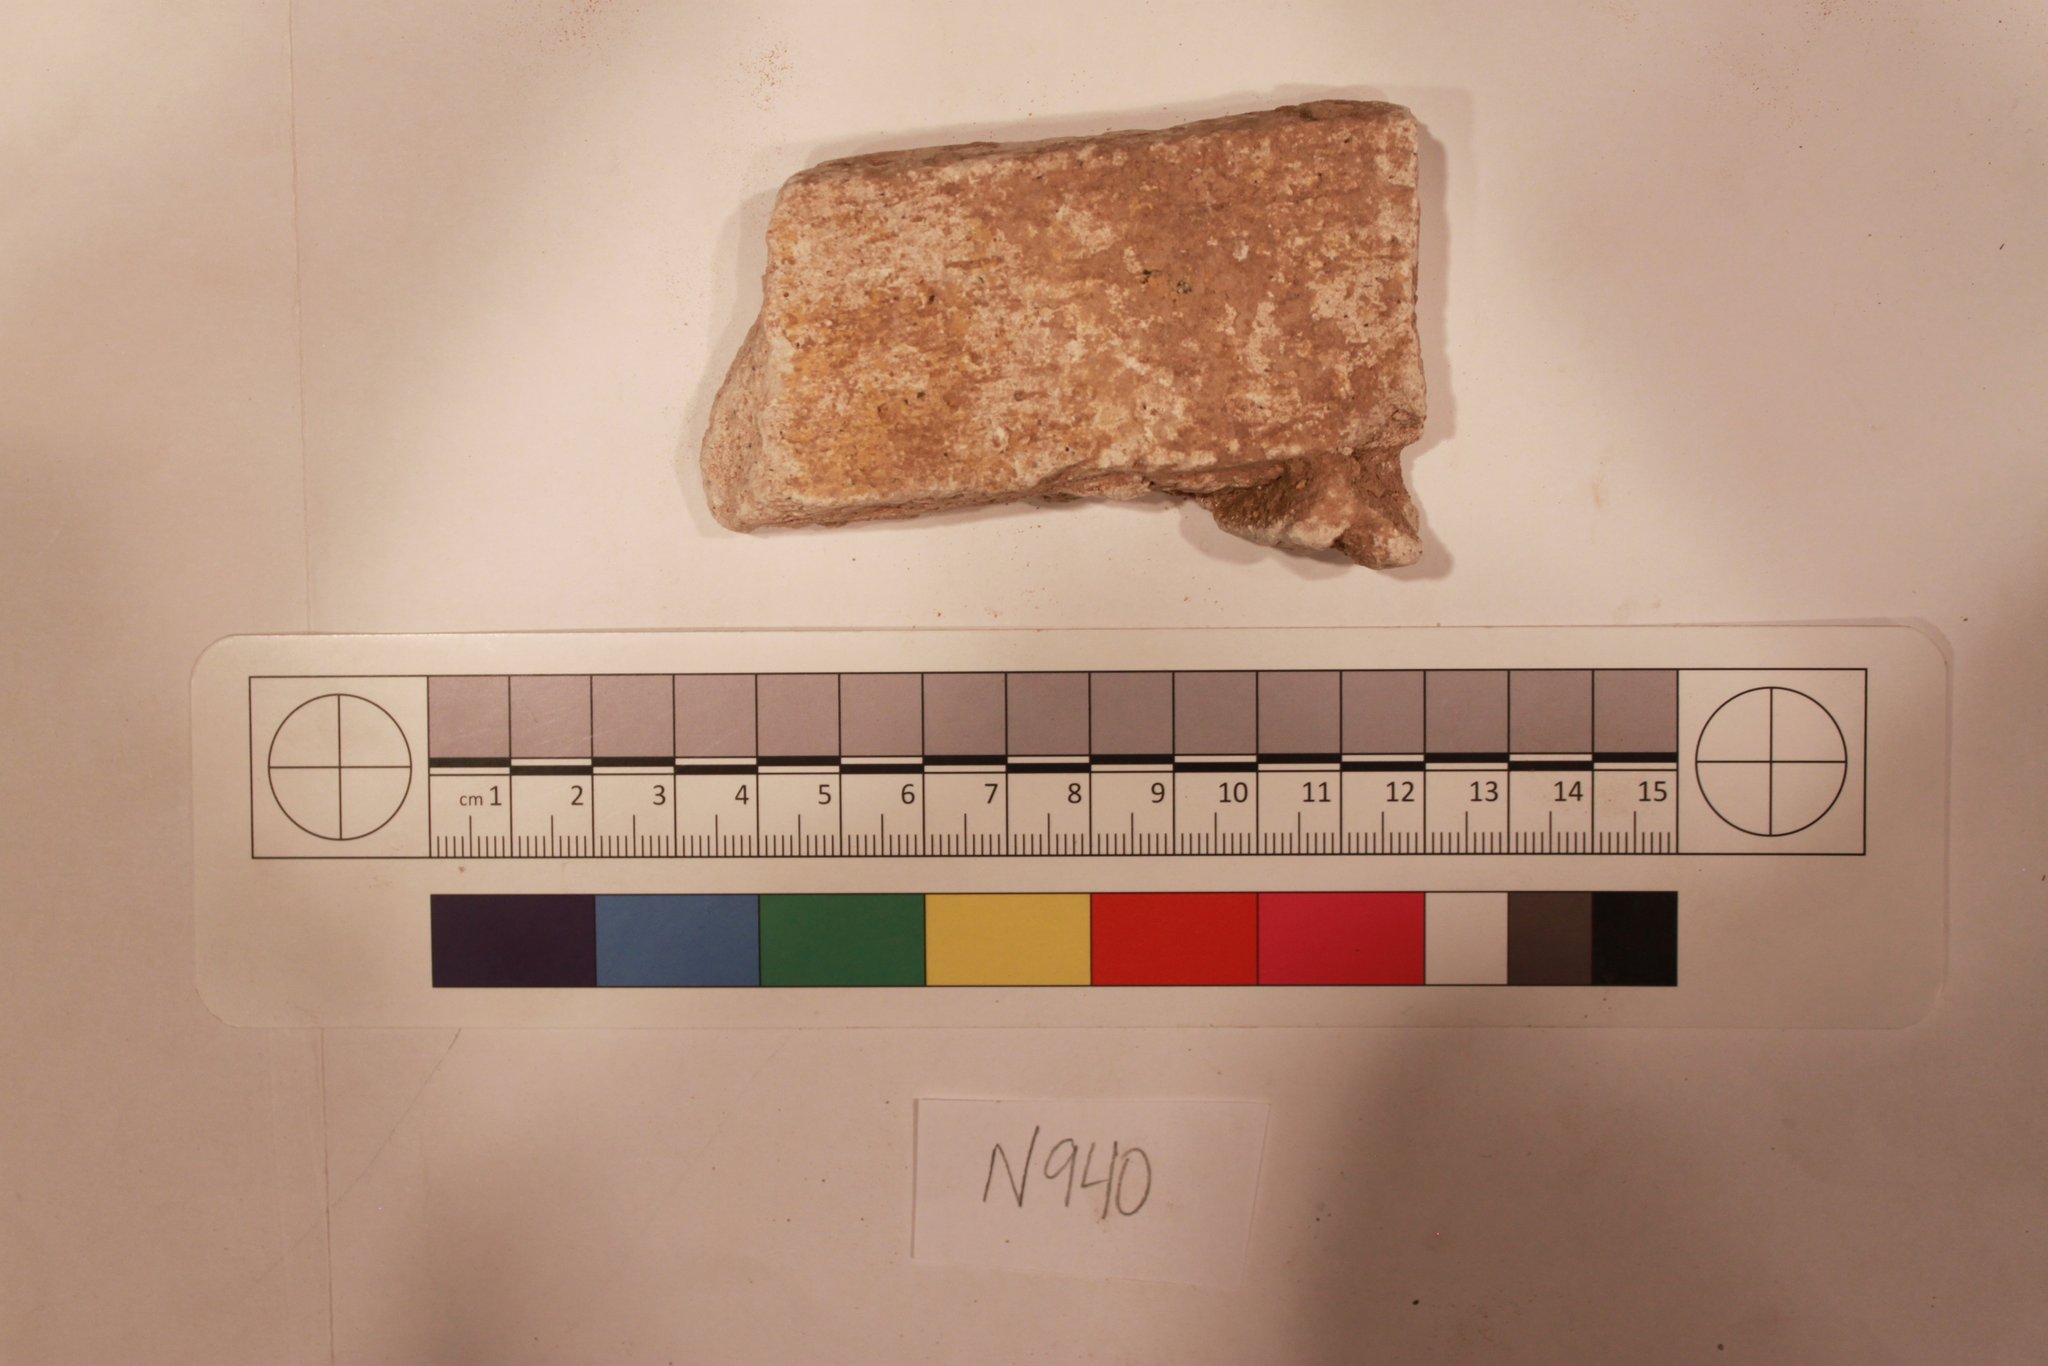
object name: fragment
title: Stucco Fragment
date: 701-1200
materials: plaster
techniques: carving, painting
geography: iran